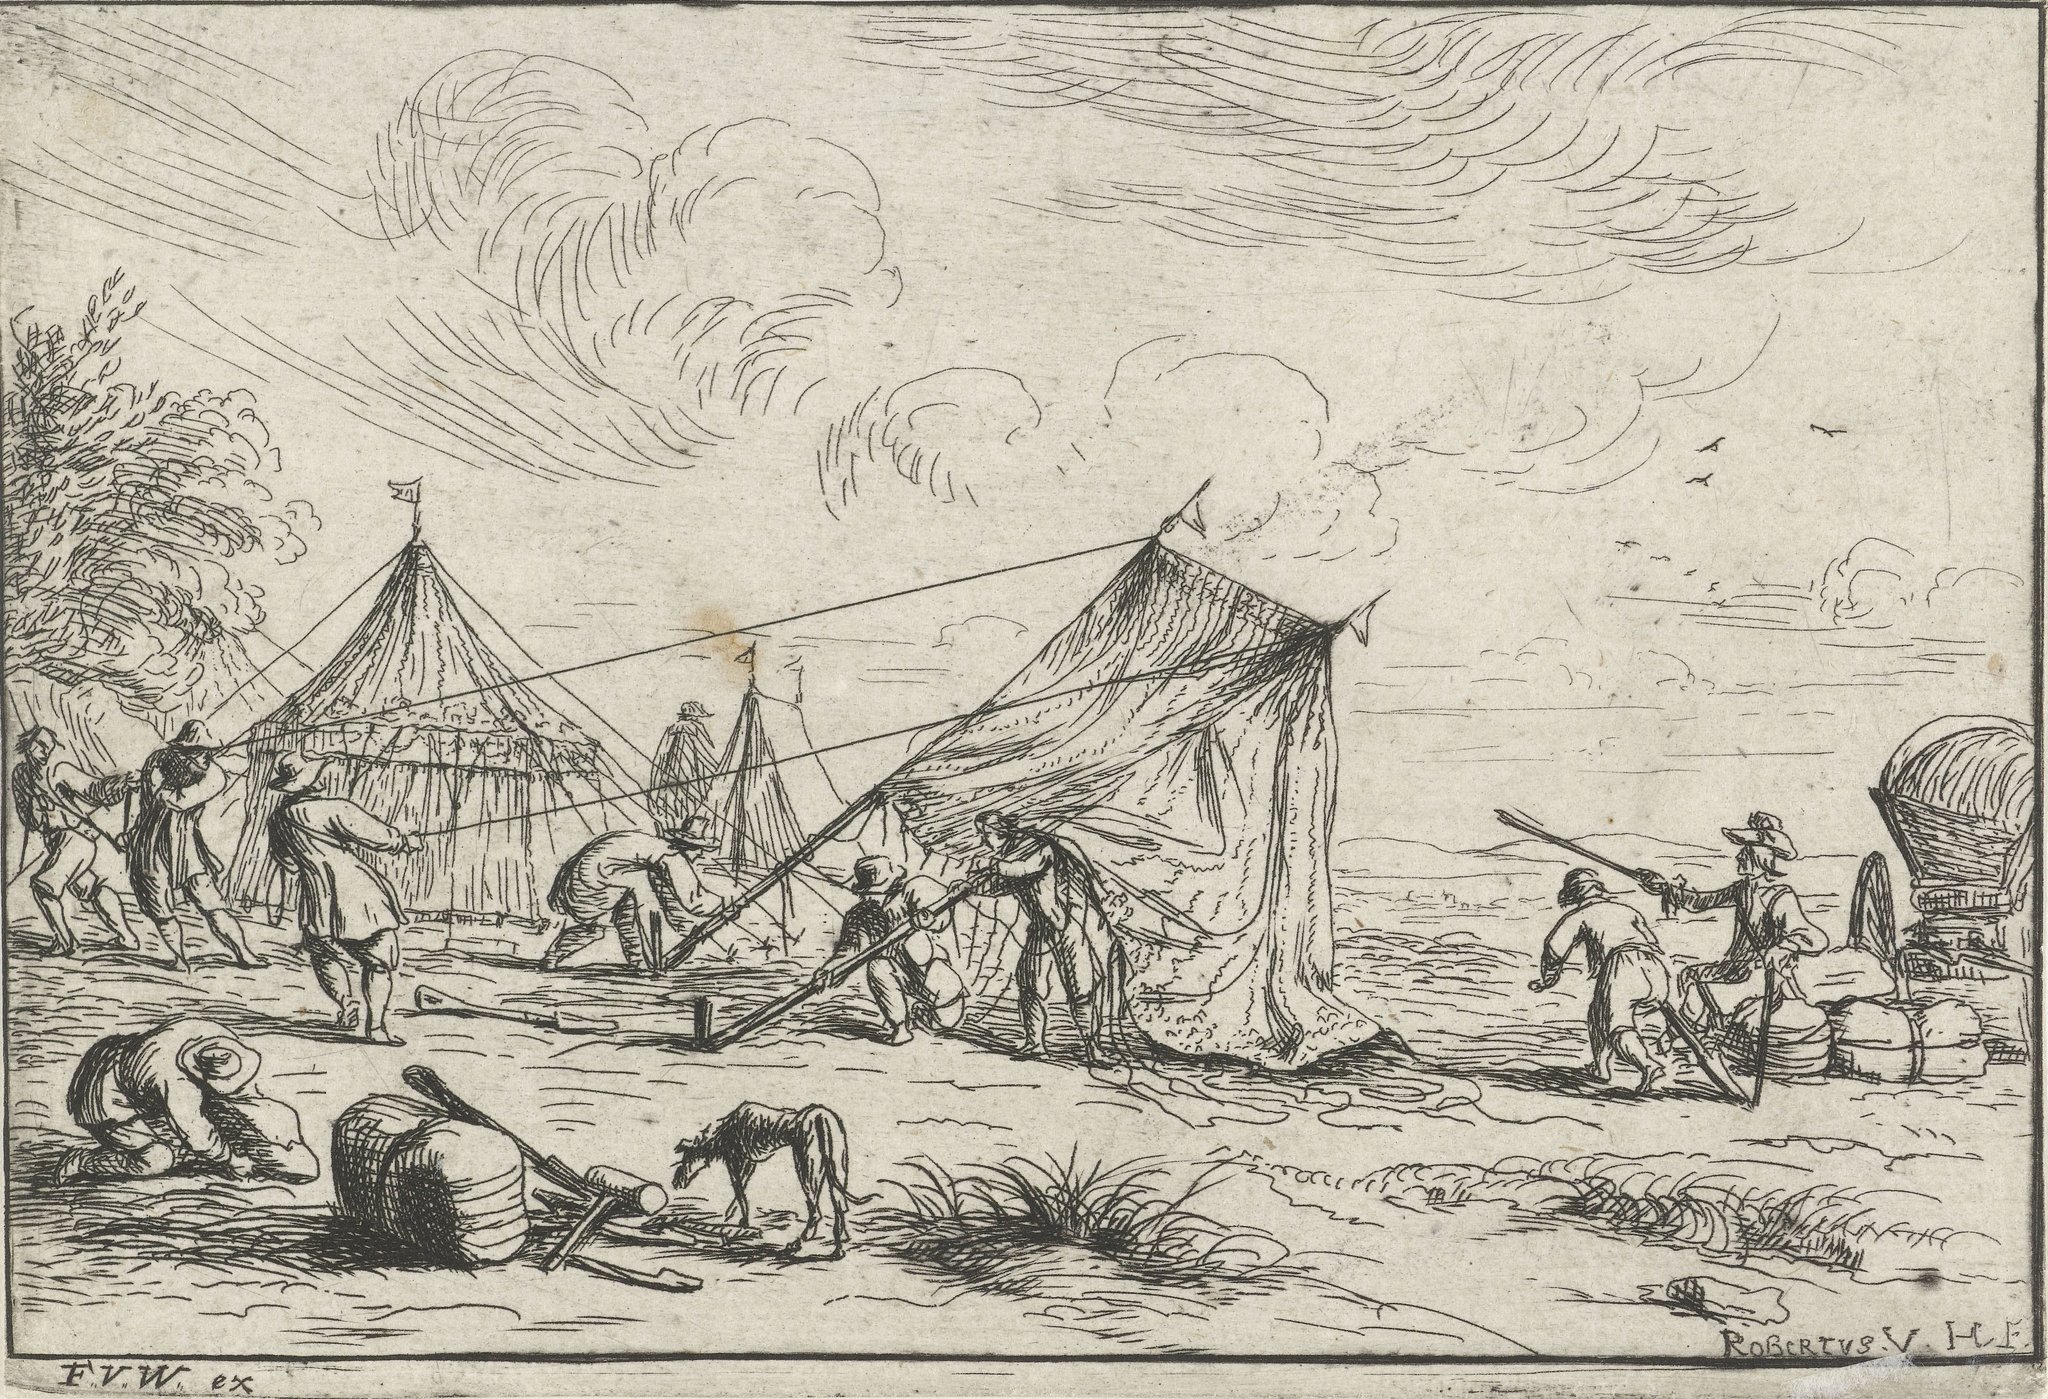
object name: print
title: Opzetten van een tent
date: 1632-1679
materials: paper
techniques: etching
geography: antwerp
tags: tent-camp, the soldier; the soldier's life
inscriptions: collector's mark: Lugt 240